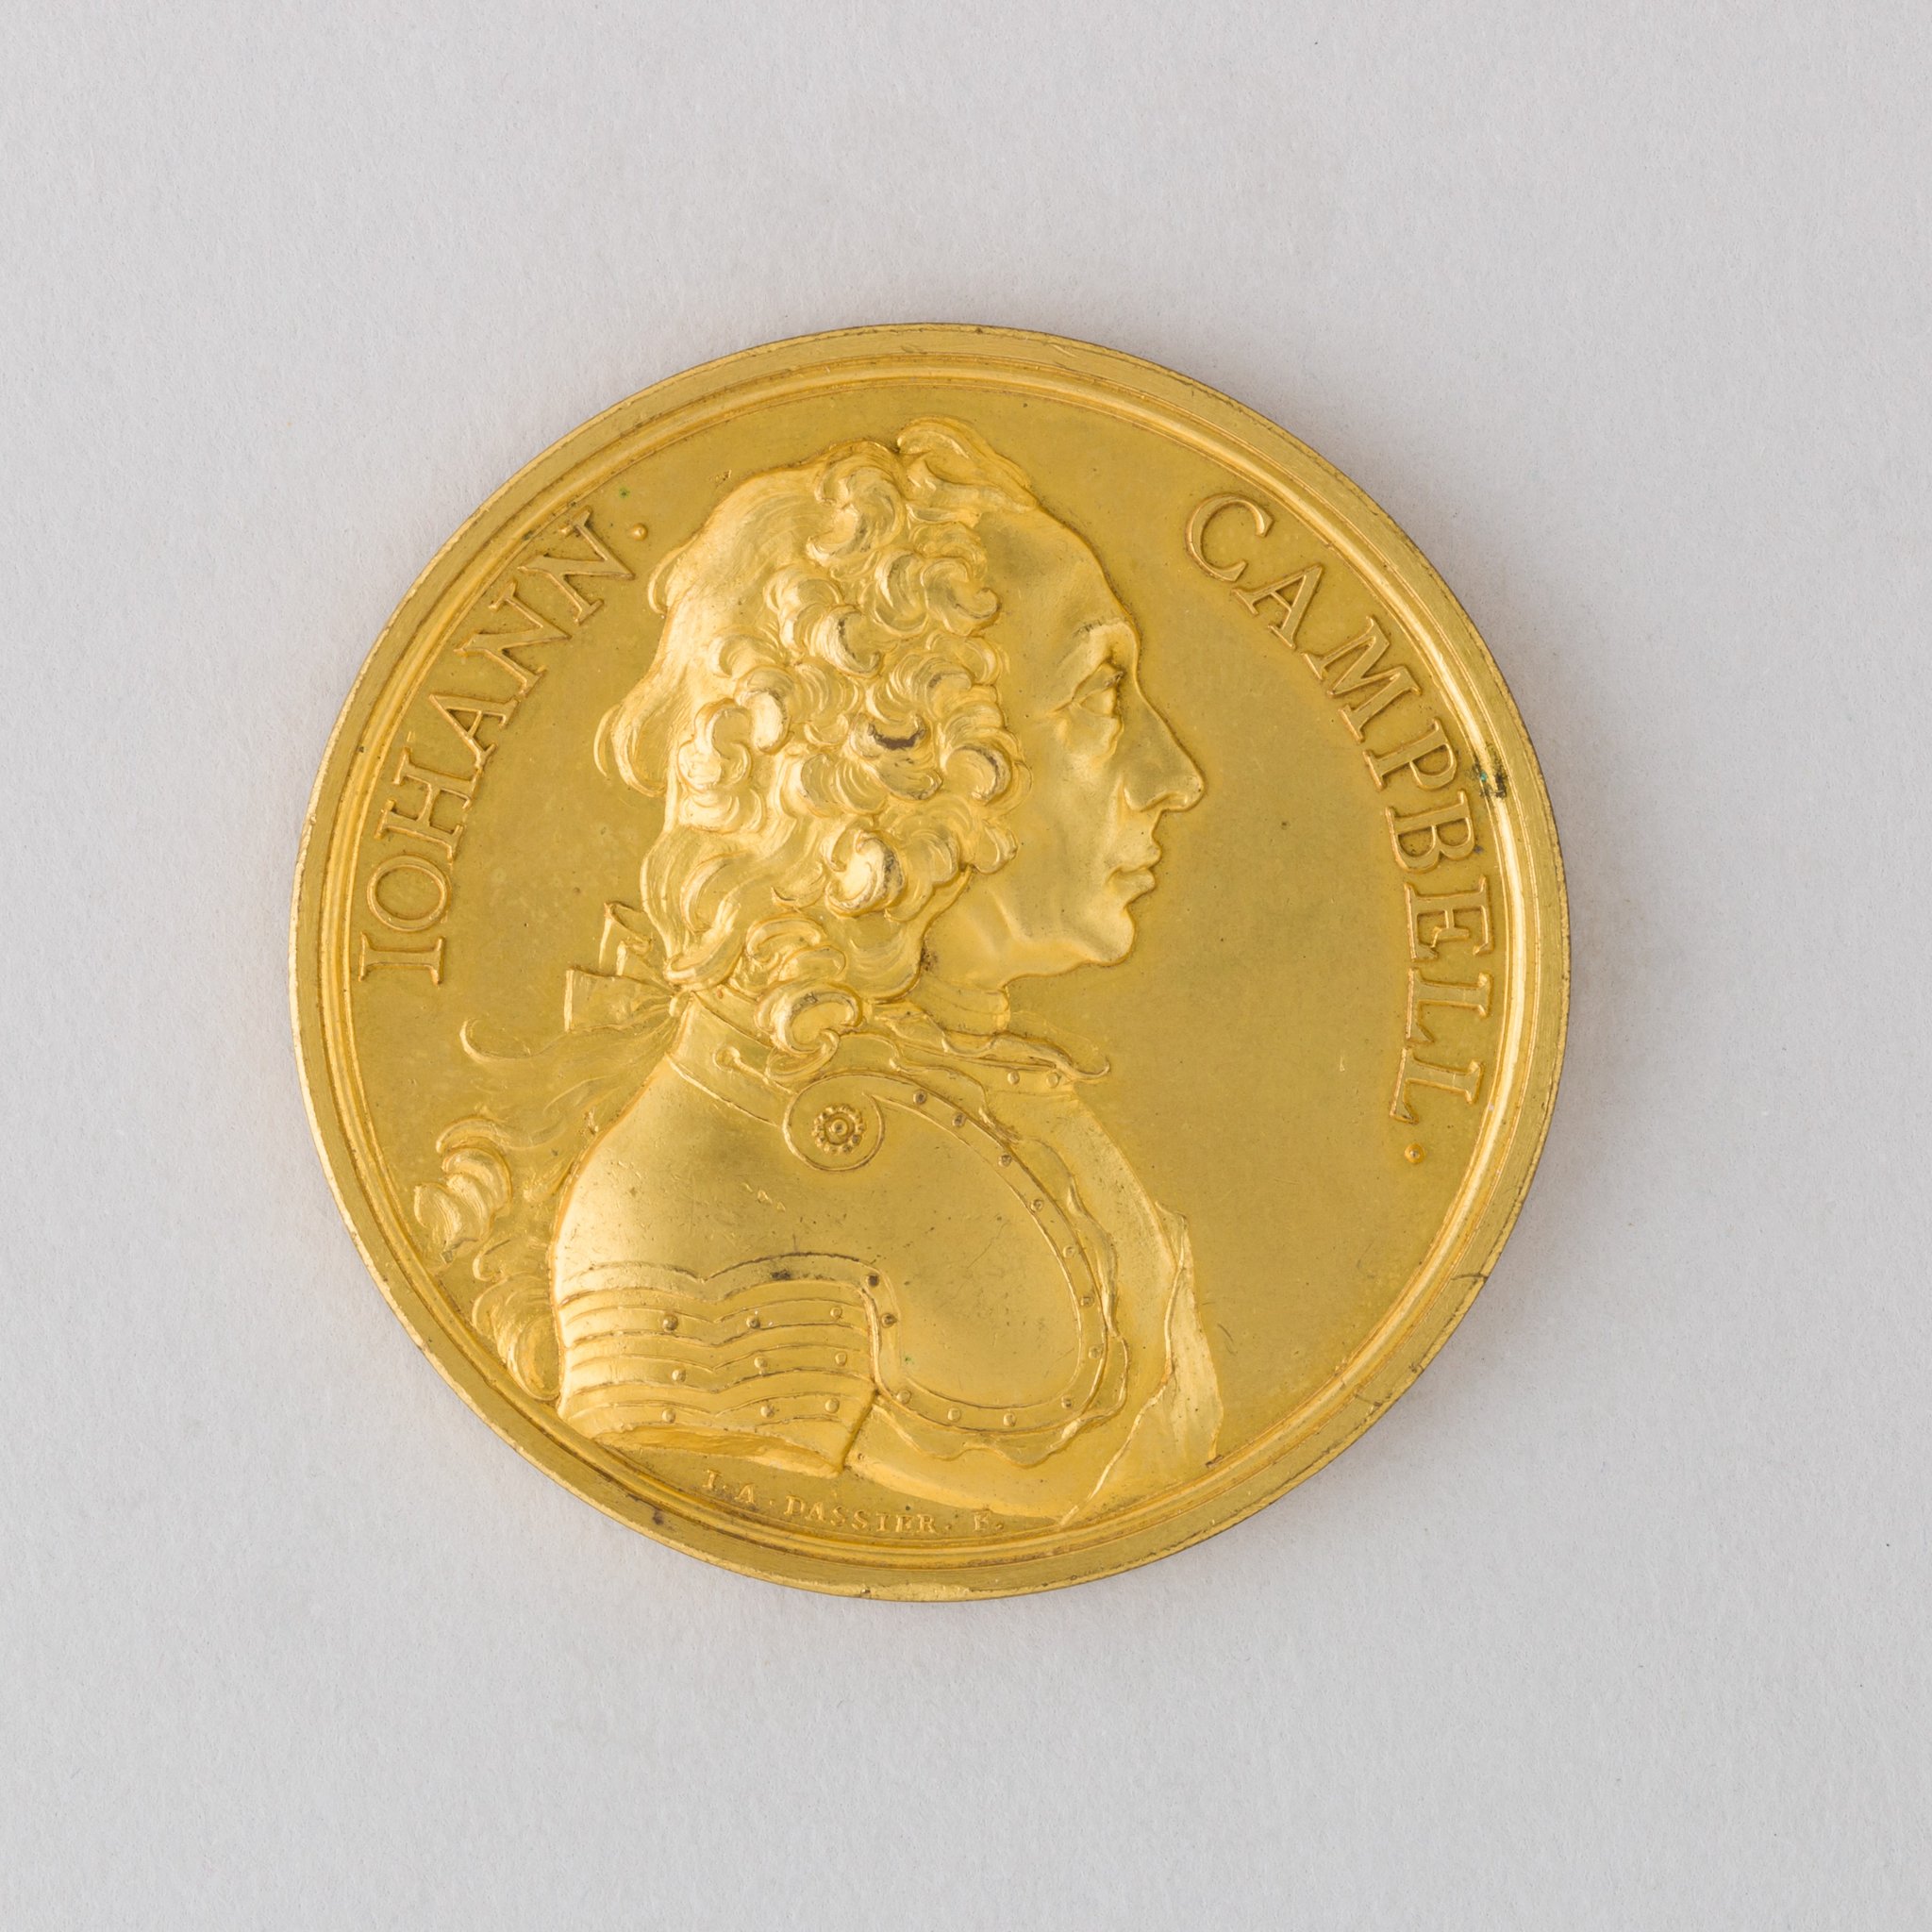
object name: medal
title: Medal Showing John Campbell, Second Duke of Argyle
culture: swiss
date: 1743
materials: gold, silver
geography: switzerland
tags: men,profiles